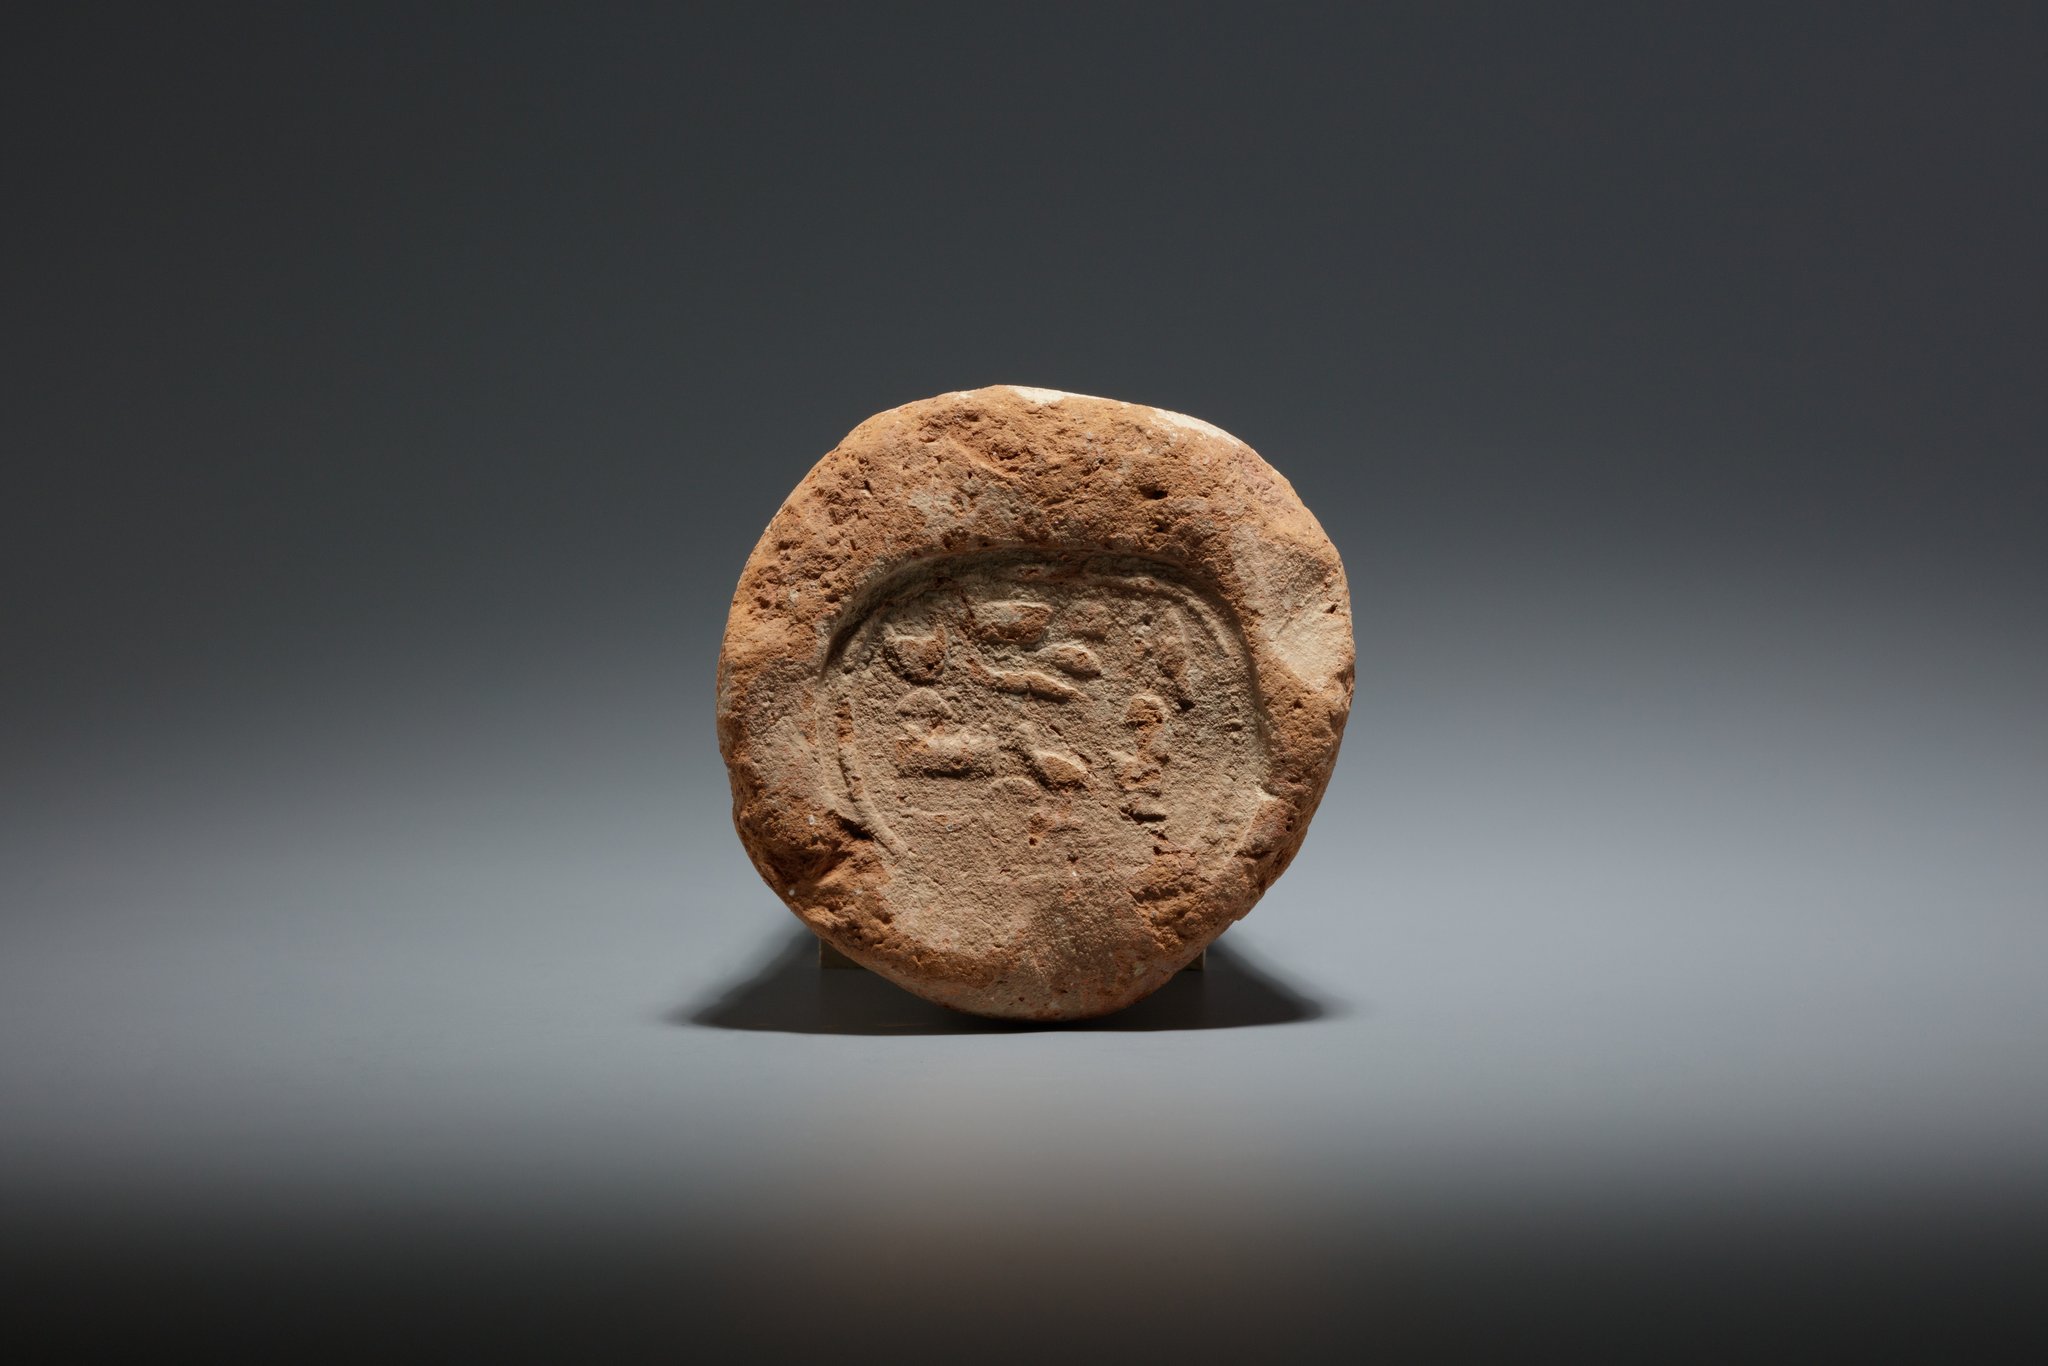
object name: cone, davy 572, sitamun, house mistress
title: Funerary Cone of the House Mistress Sitamun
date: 1550-1295 BCE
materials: pottery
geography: egypt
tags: hieroglyphs